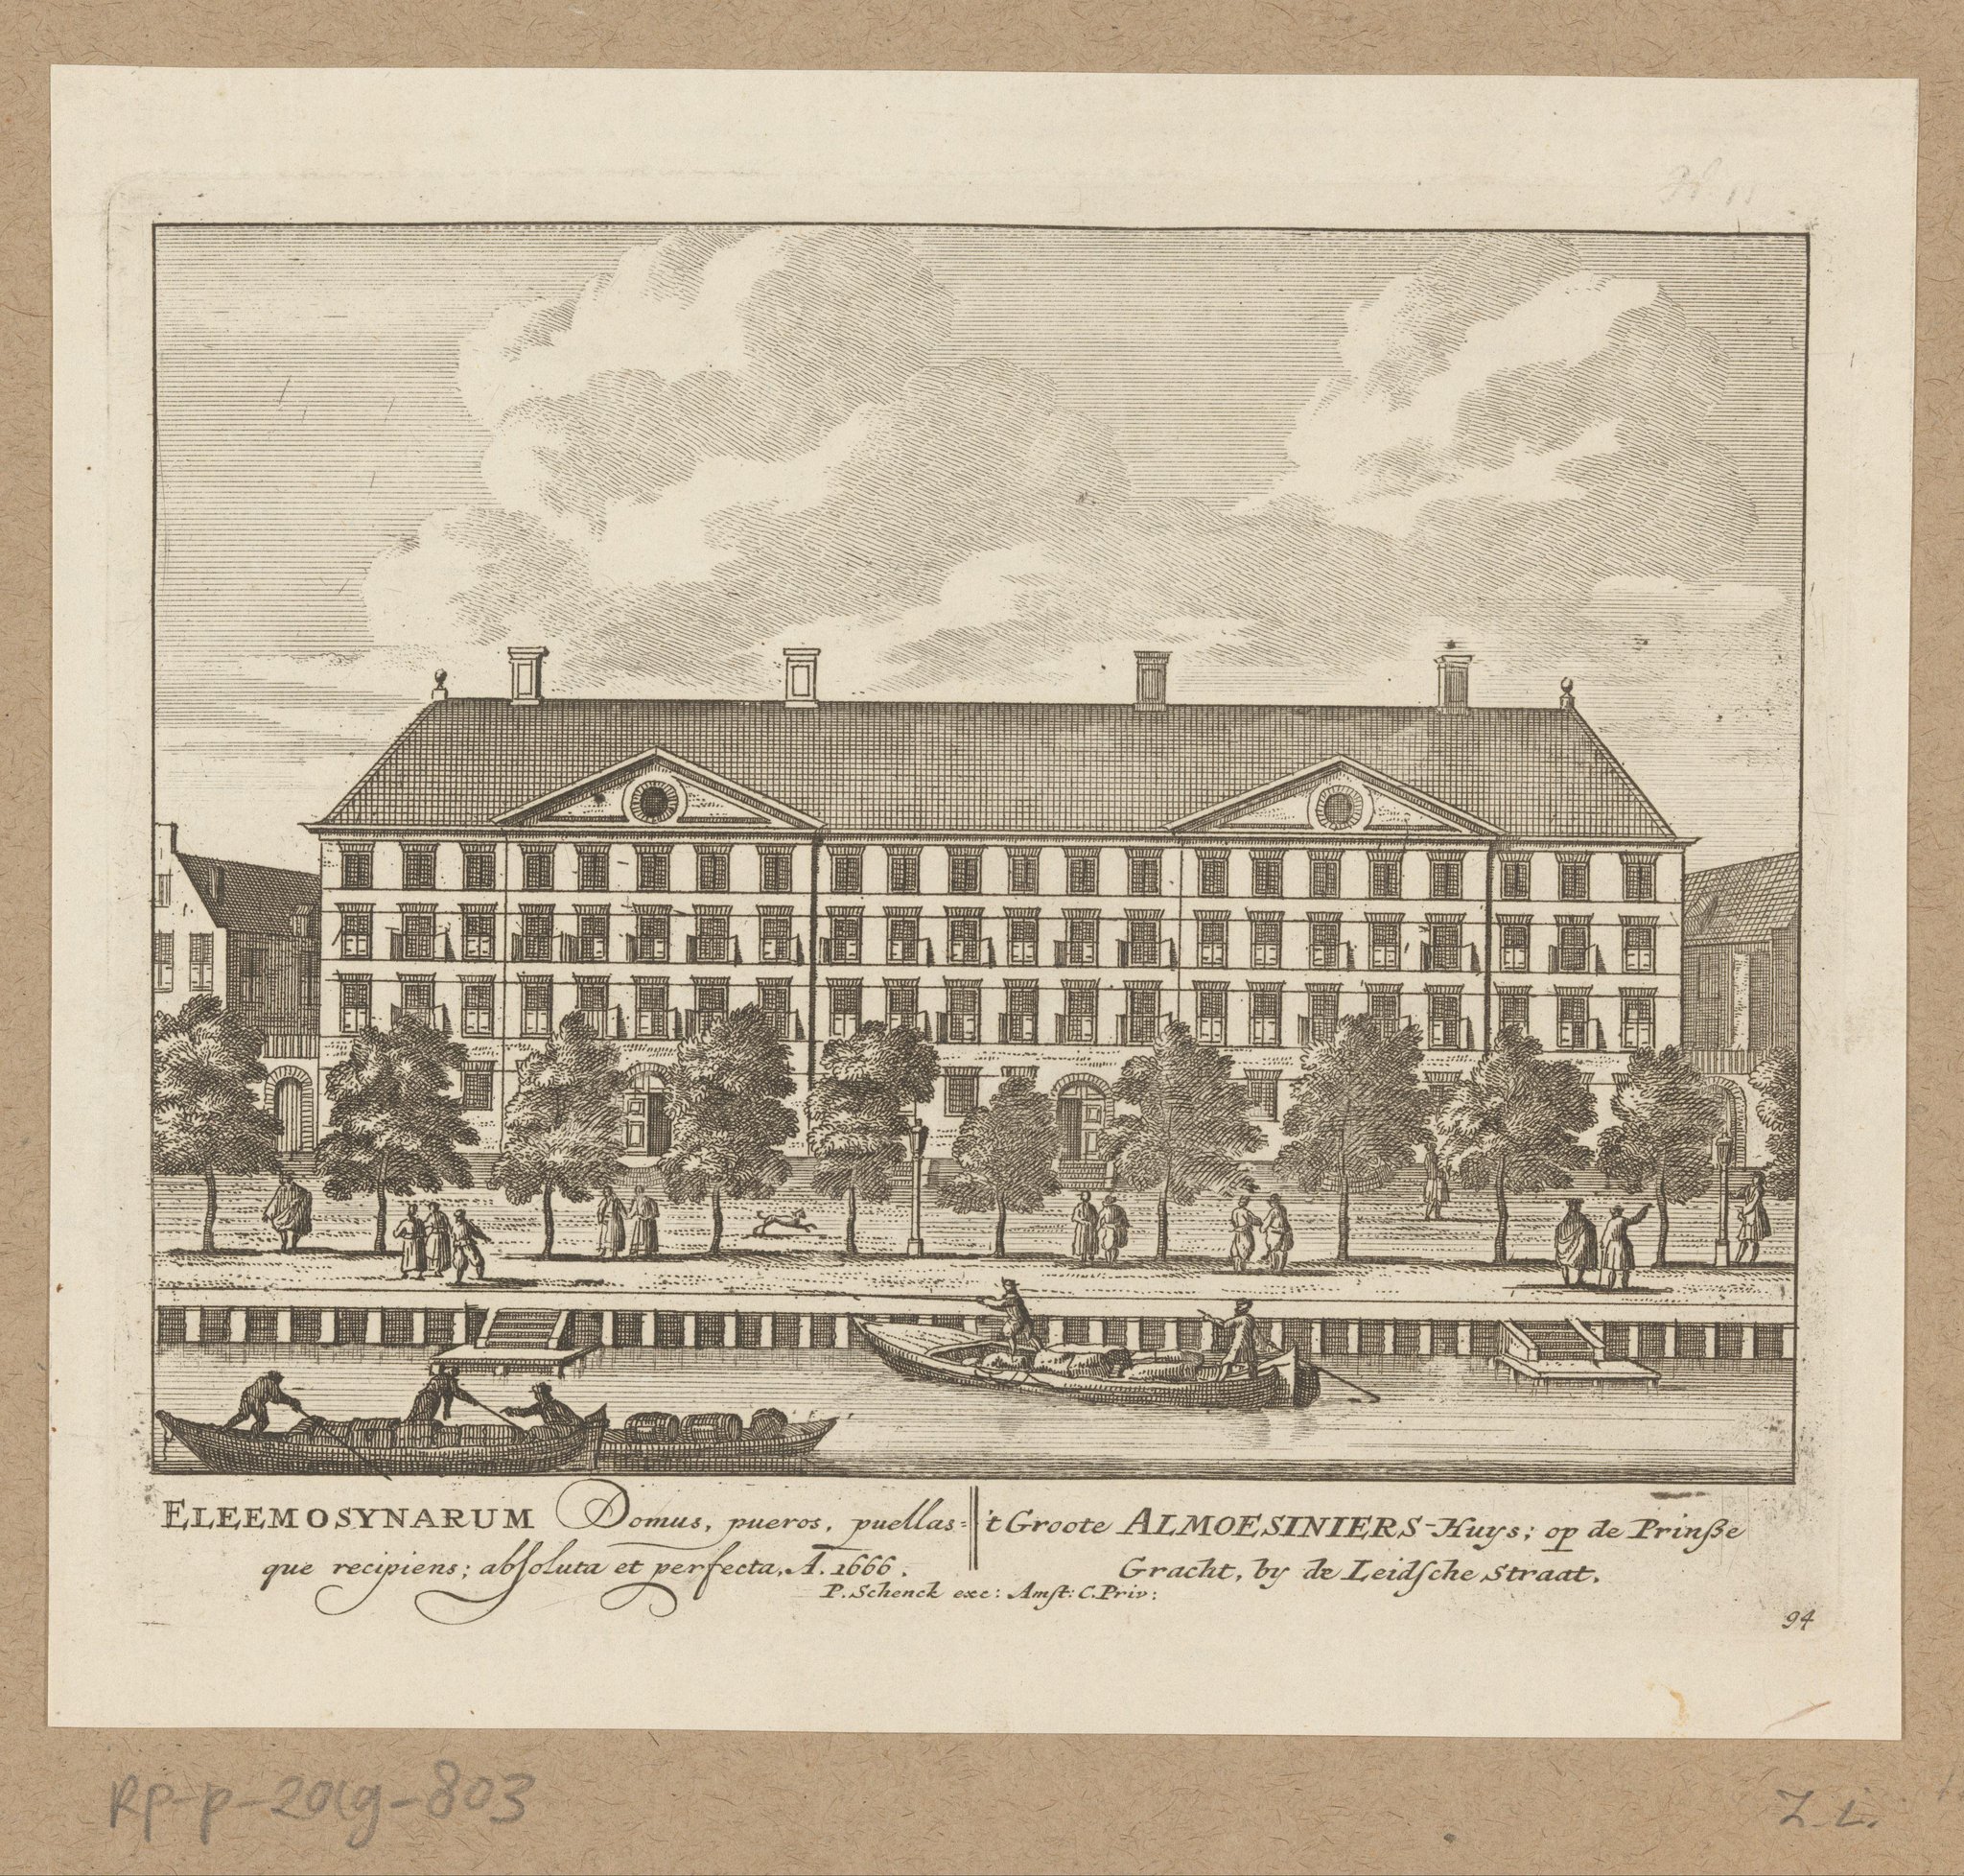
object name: print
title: Gezicht op het Aalmoezeniersweeshuis te Amsterdam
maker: Anonymous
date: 1710-1711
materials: paper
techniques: etching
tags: public welfare, orphanage, canals, waters (in city) (+ city(-scape) with figures, staffage), street (+ city(-scape) with figures, staffage)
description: Huidige staat van prent ook gebruikt in: 100 Afbeeldinge der voornaamste gebouwen van Amsterdam. Amsterdam: Pieter Schenk (I), s.a. [1710-1711]. En in: 100 Afbeeldinge der voornaamste gebouwen van Amsterdam. Amsterdam: Barent Greve, s.a. [1757-1766].* *In de tweede uitgave, uitgegeven door Barent Greve, is alleen de titelprent aangepast. De overige prenten zijn onveranderd gebleven.